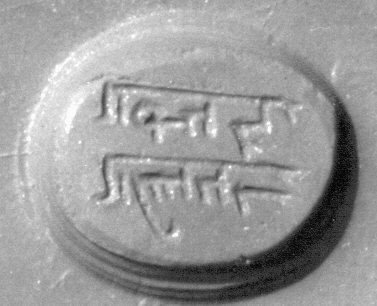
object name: stamp seal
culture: islamic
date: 701-900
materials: gemstone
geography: iran